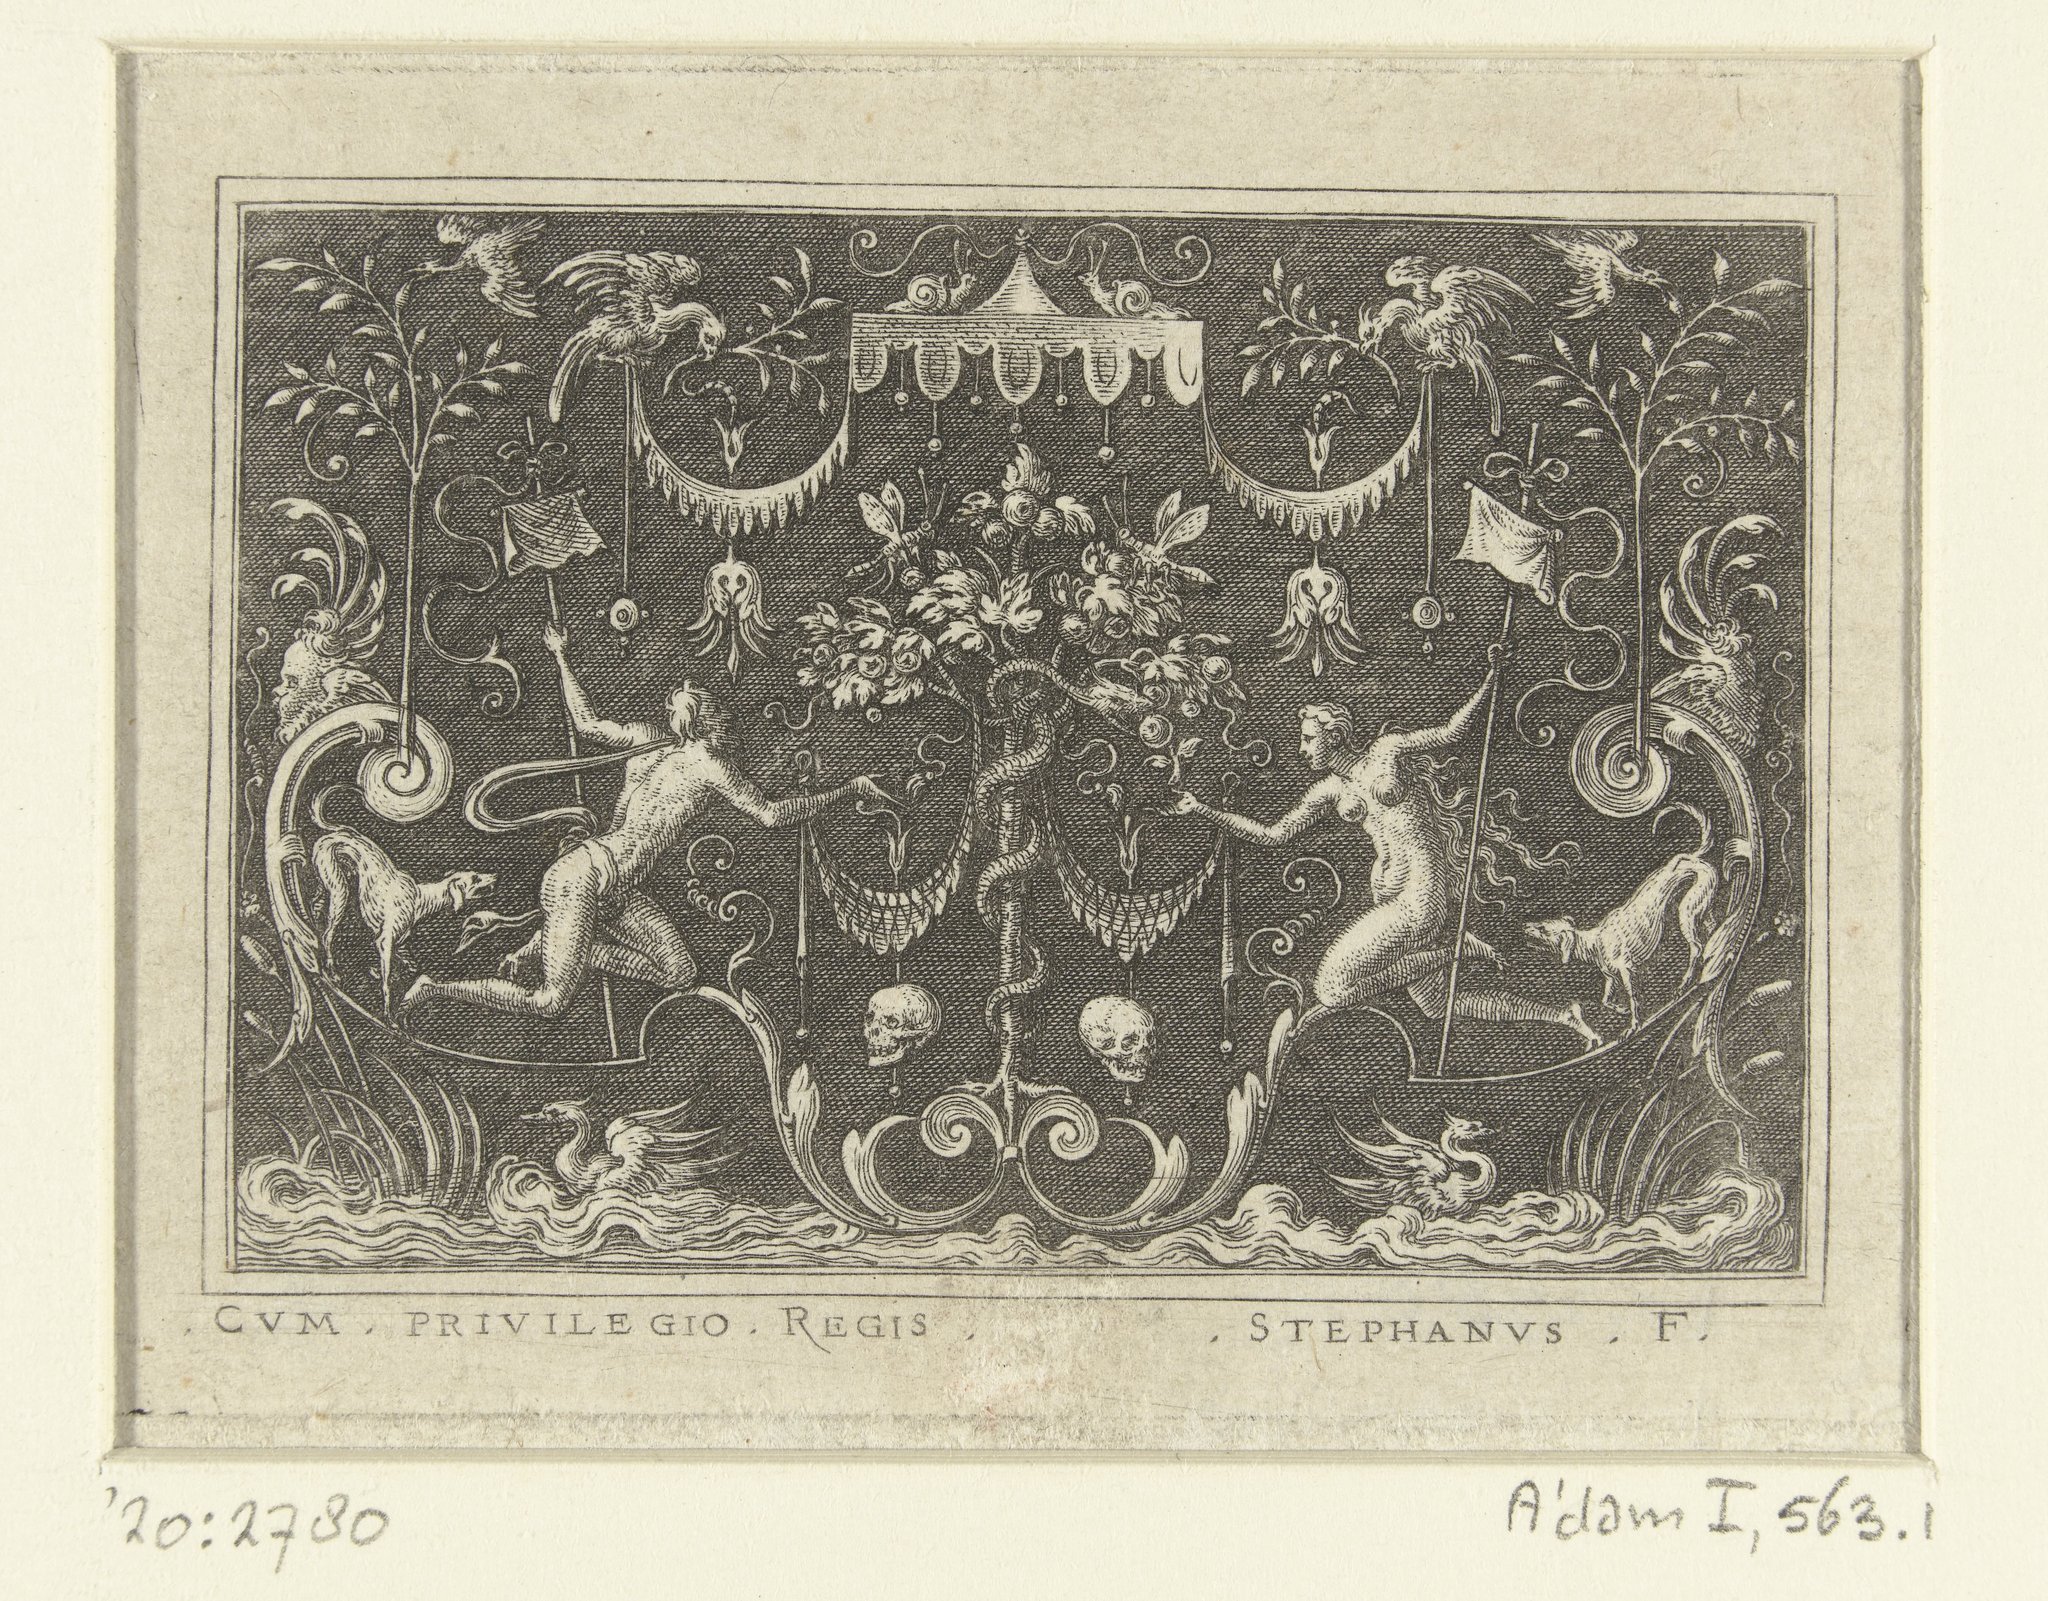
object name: ornament print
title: De zondeval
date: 1528-1583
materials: paper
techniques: engraving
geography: france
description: Zowel Adam als Eva zitten geknield op een voluut, met een stok waaraan een vaandel hangt. Zij reiken naar de appels aan de boom in het midden. Uit serie van 6 bladen.